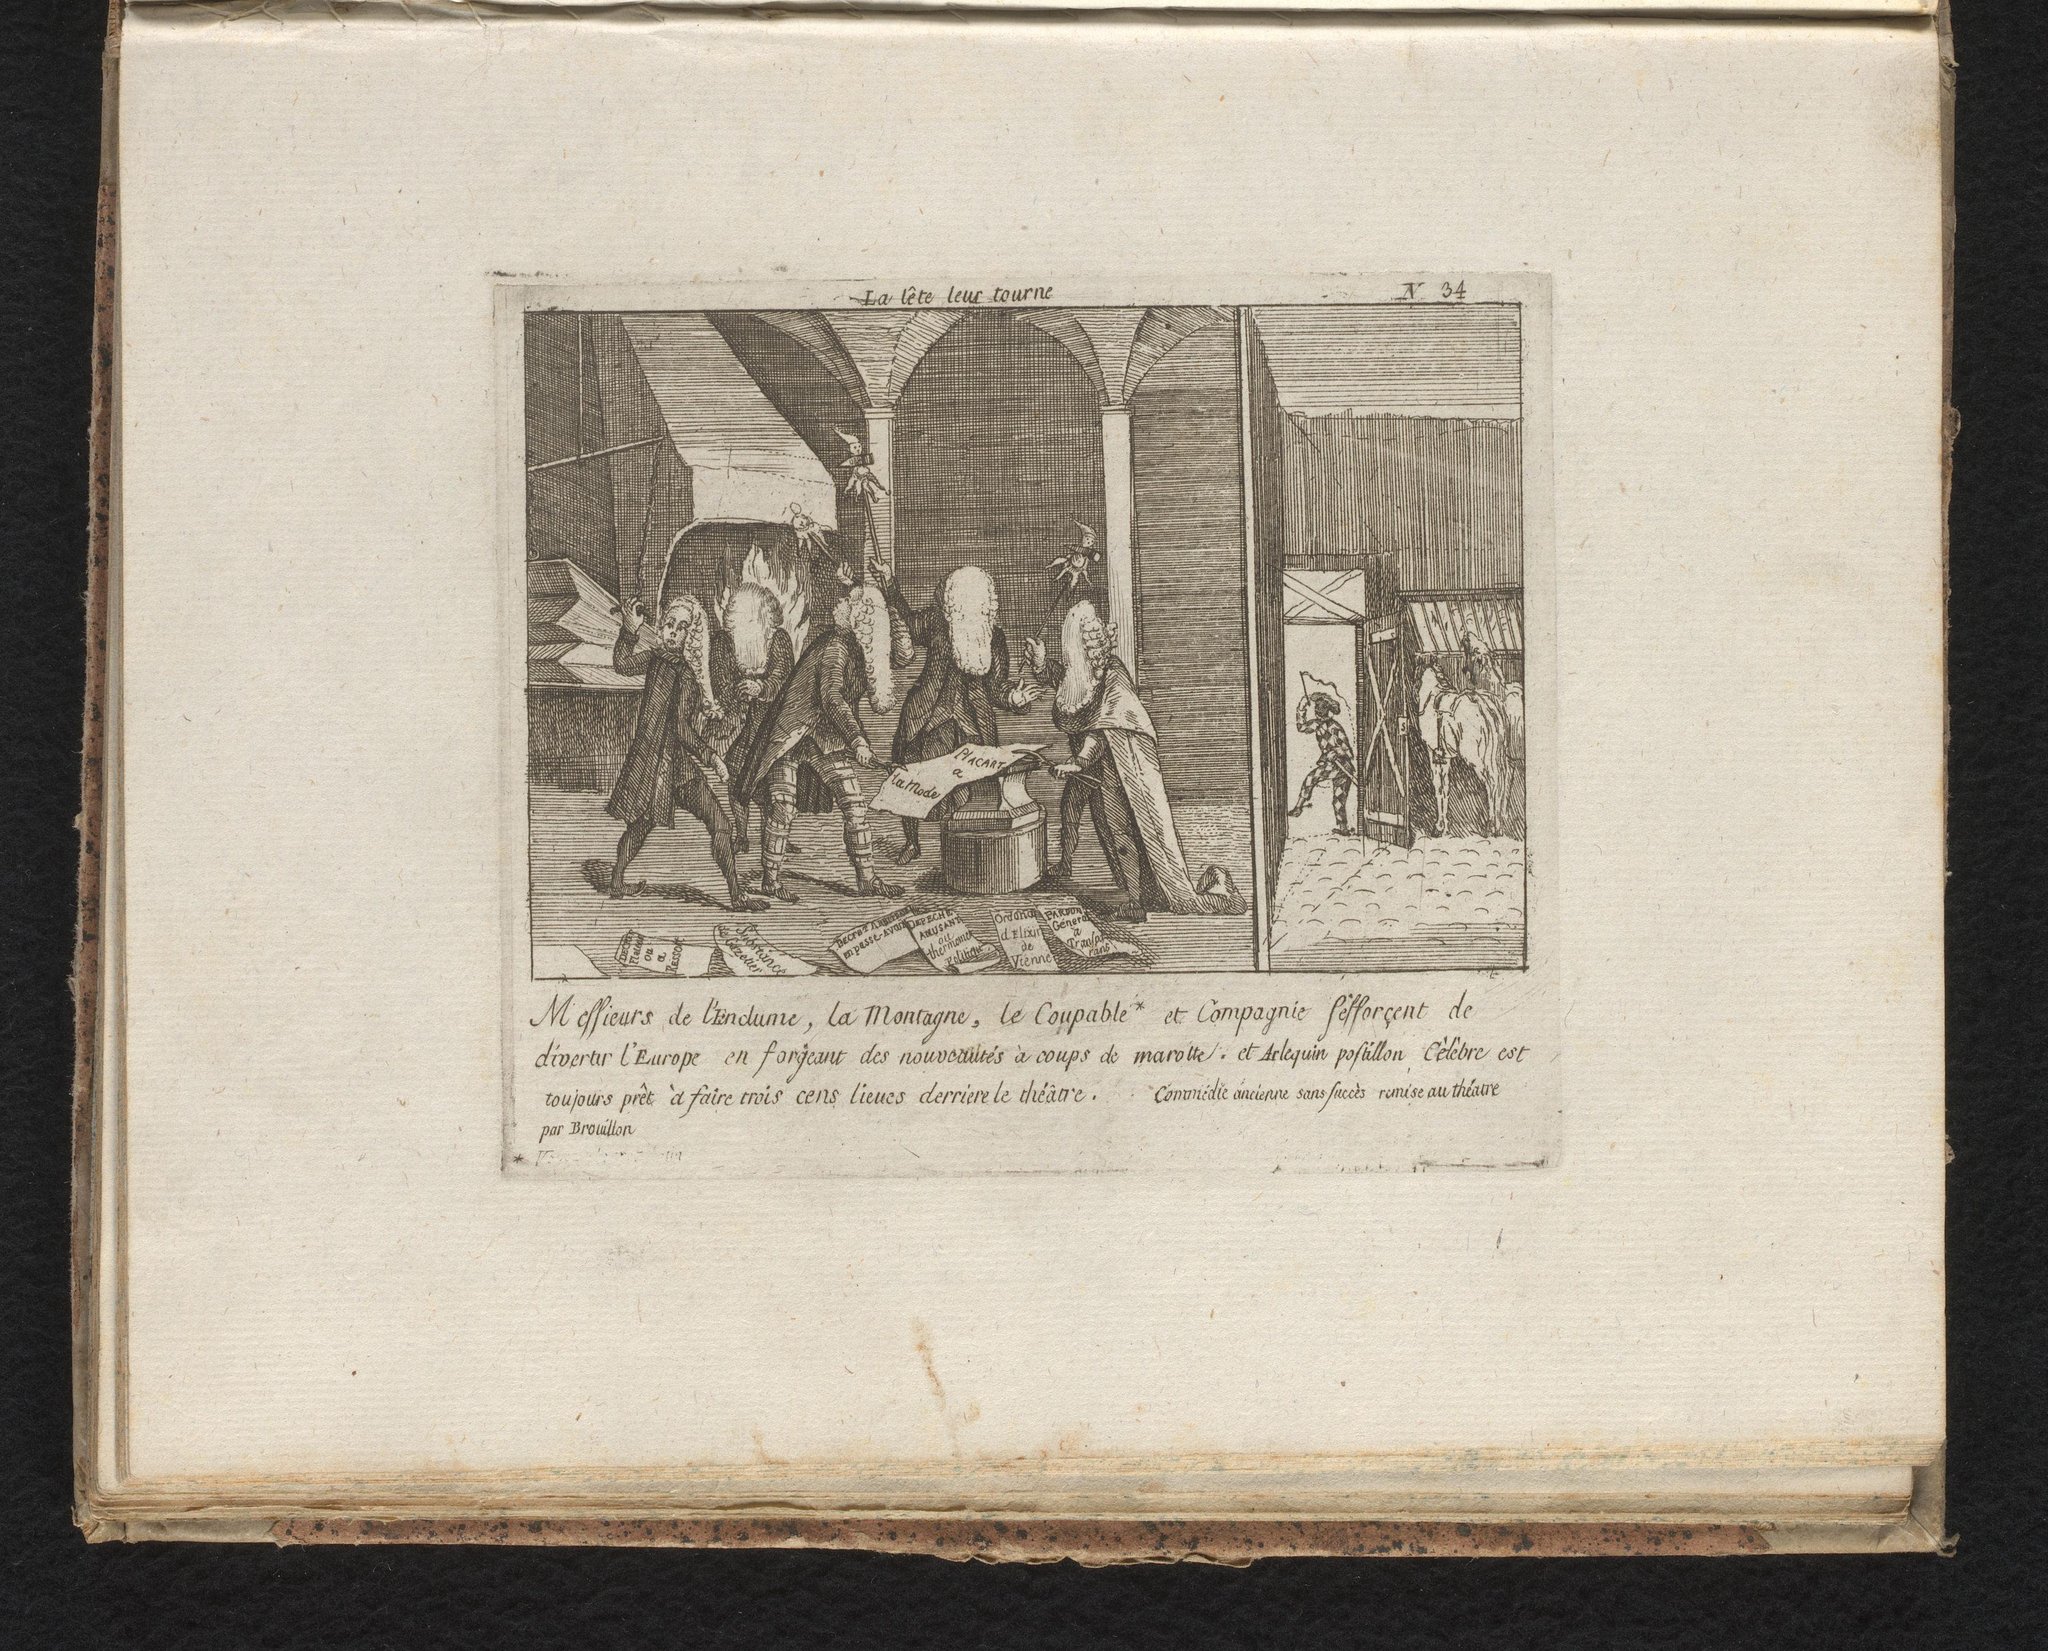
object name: print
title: Smeden van het plakkaat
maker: Anonymous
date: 1787-1790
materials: paper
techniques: engraving, etching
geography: southern netherlands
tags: smith, blacksmith, brabant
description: Spotprent waarin drie mannen met grote pruiken en afgewende hoofden een plakkaat smeden op een aambeeld. Op de grond liggen meer documenten. Met onderschrift van 3 regels in het Frans. Genummerd rechtsboven: No. 34. Onderdeel van de gebundelde verzameling prenten betrekking hebbend op de gebeurtenissen van de Brabantse Omwenteling en de periode 1787-1790.